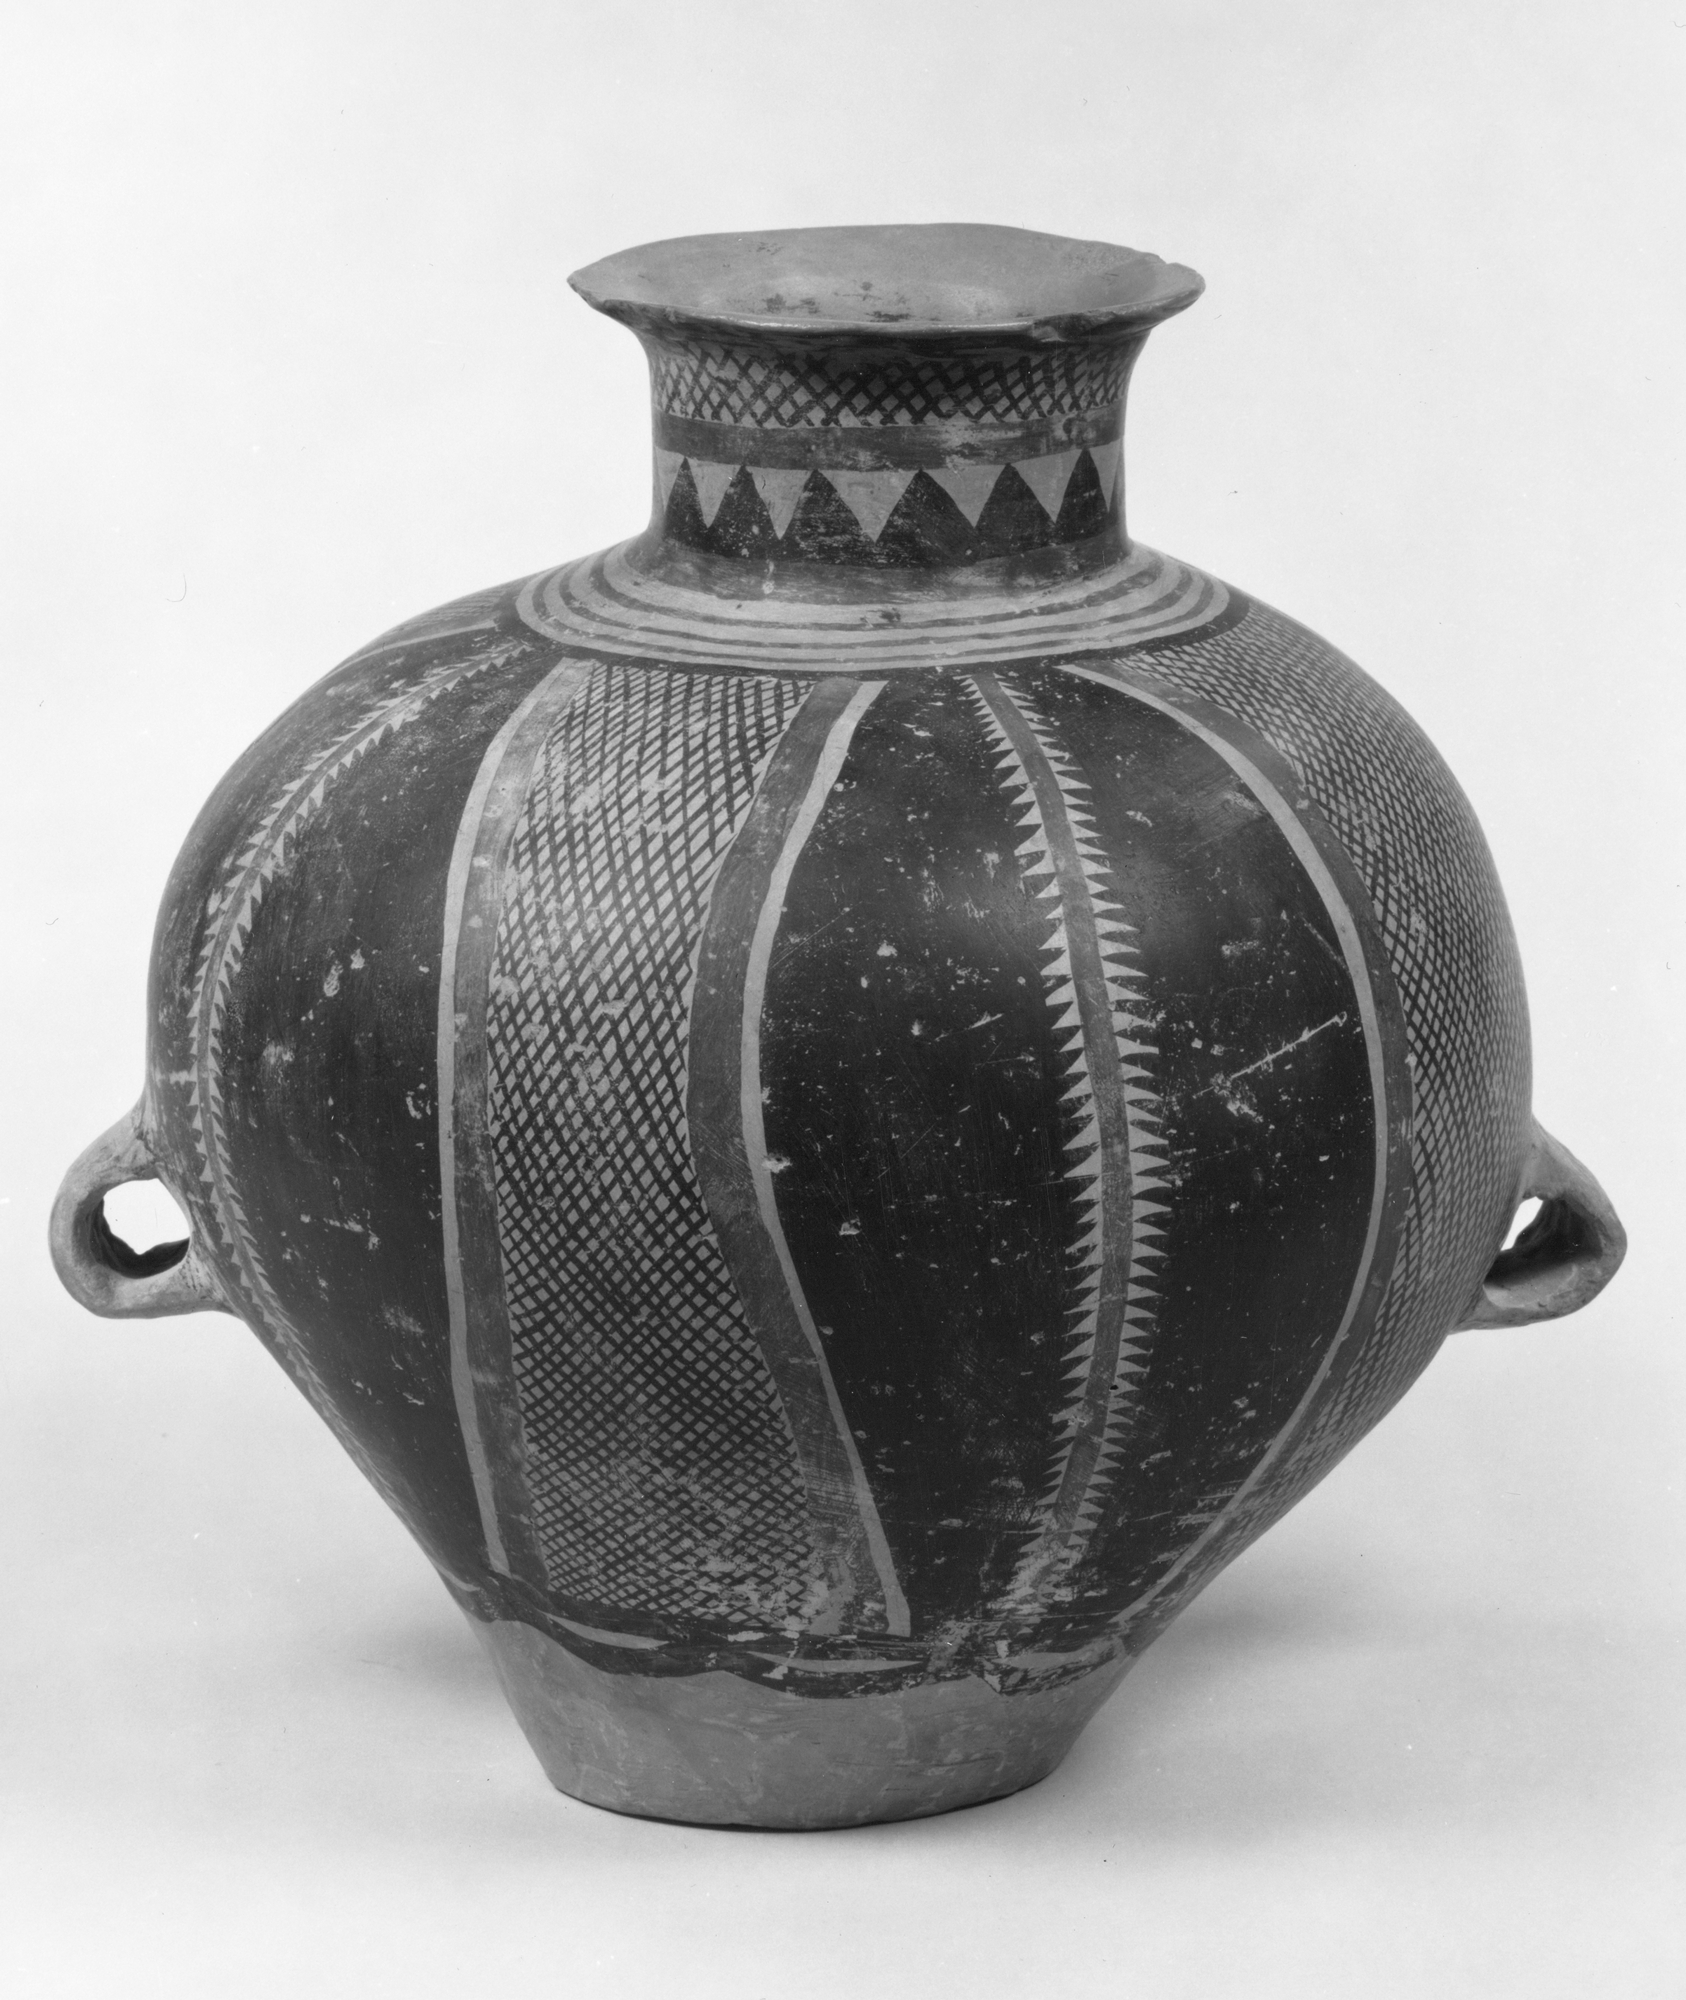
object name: jar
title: Jar (Guan)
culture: chinese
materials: earthenware, pigment